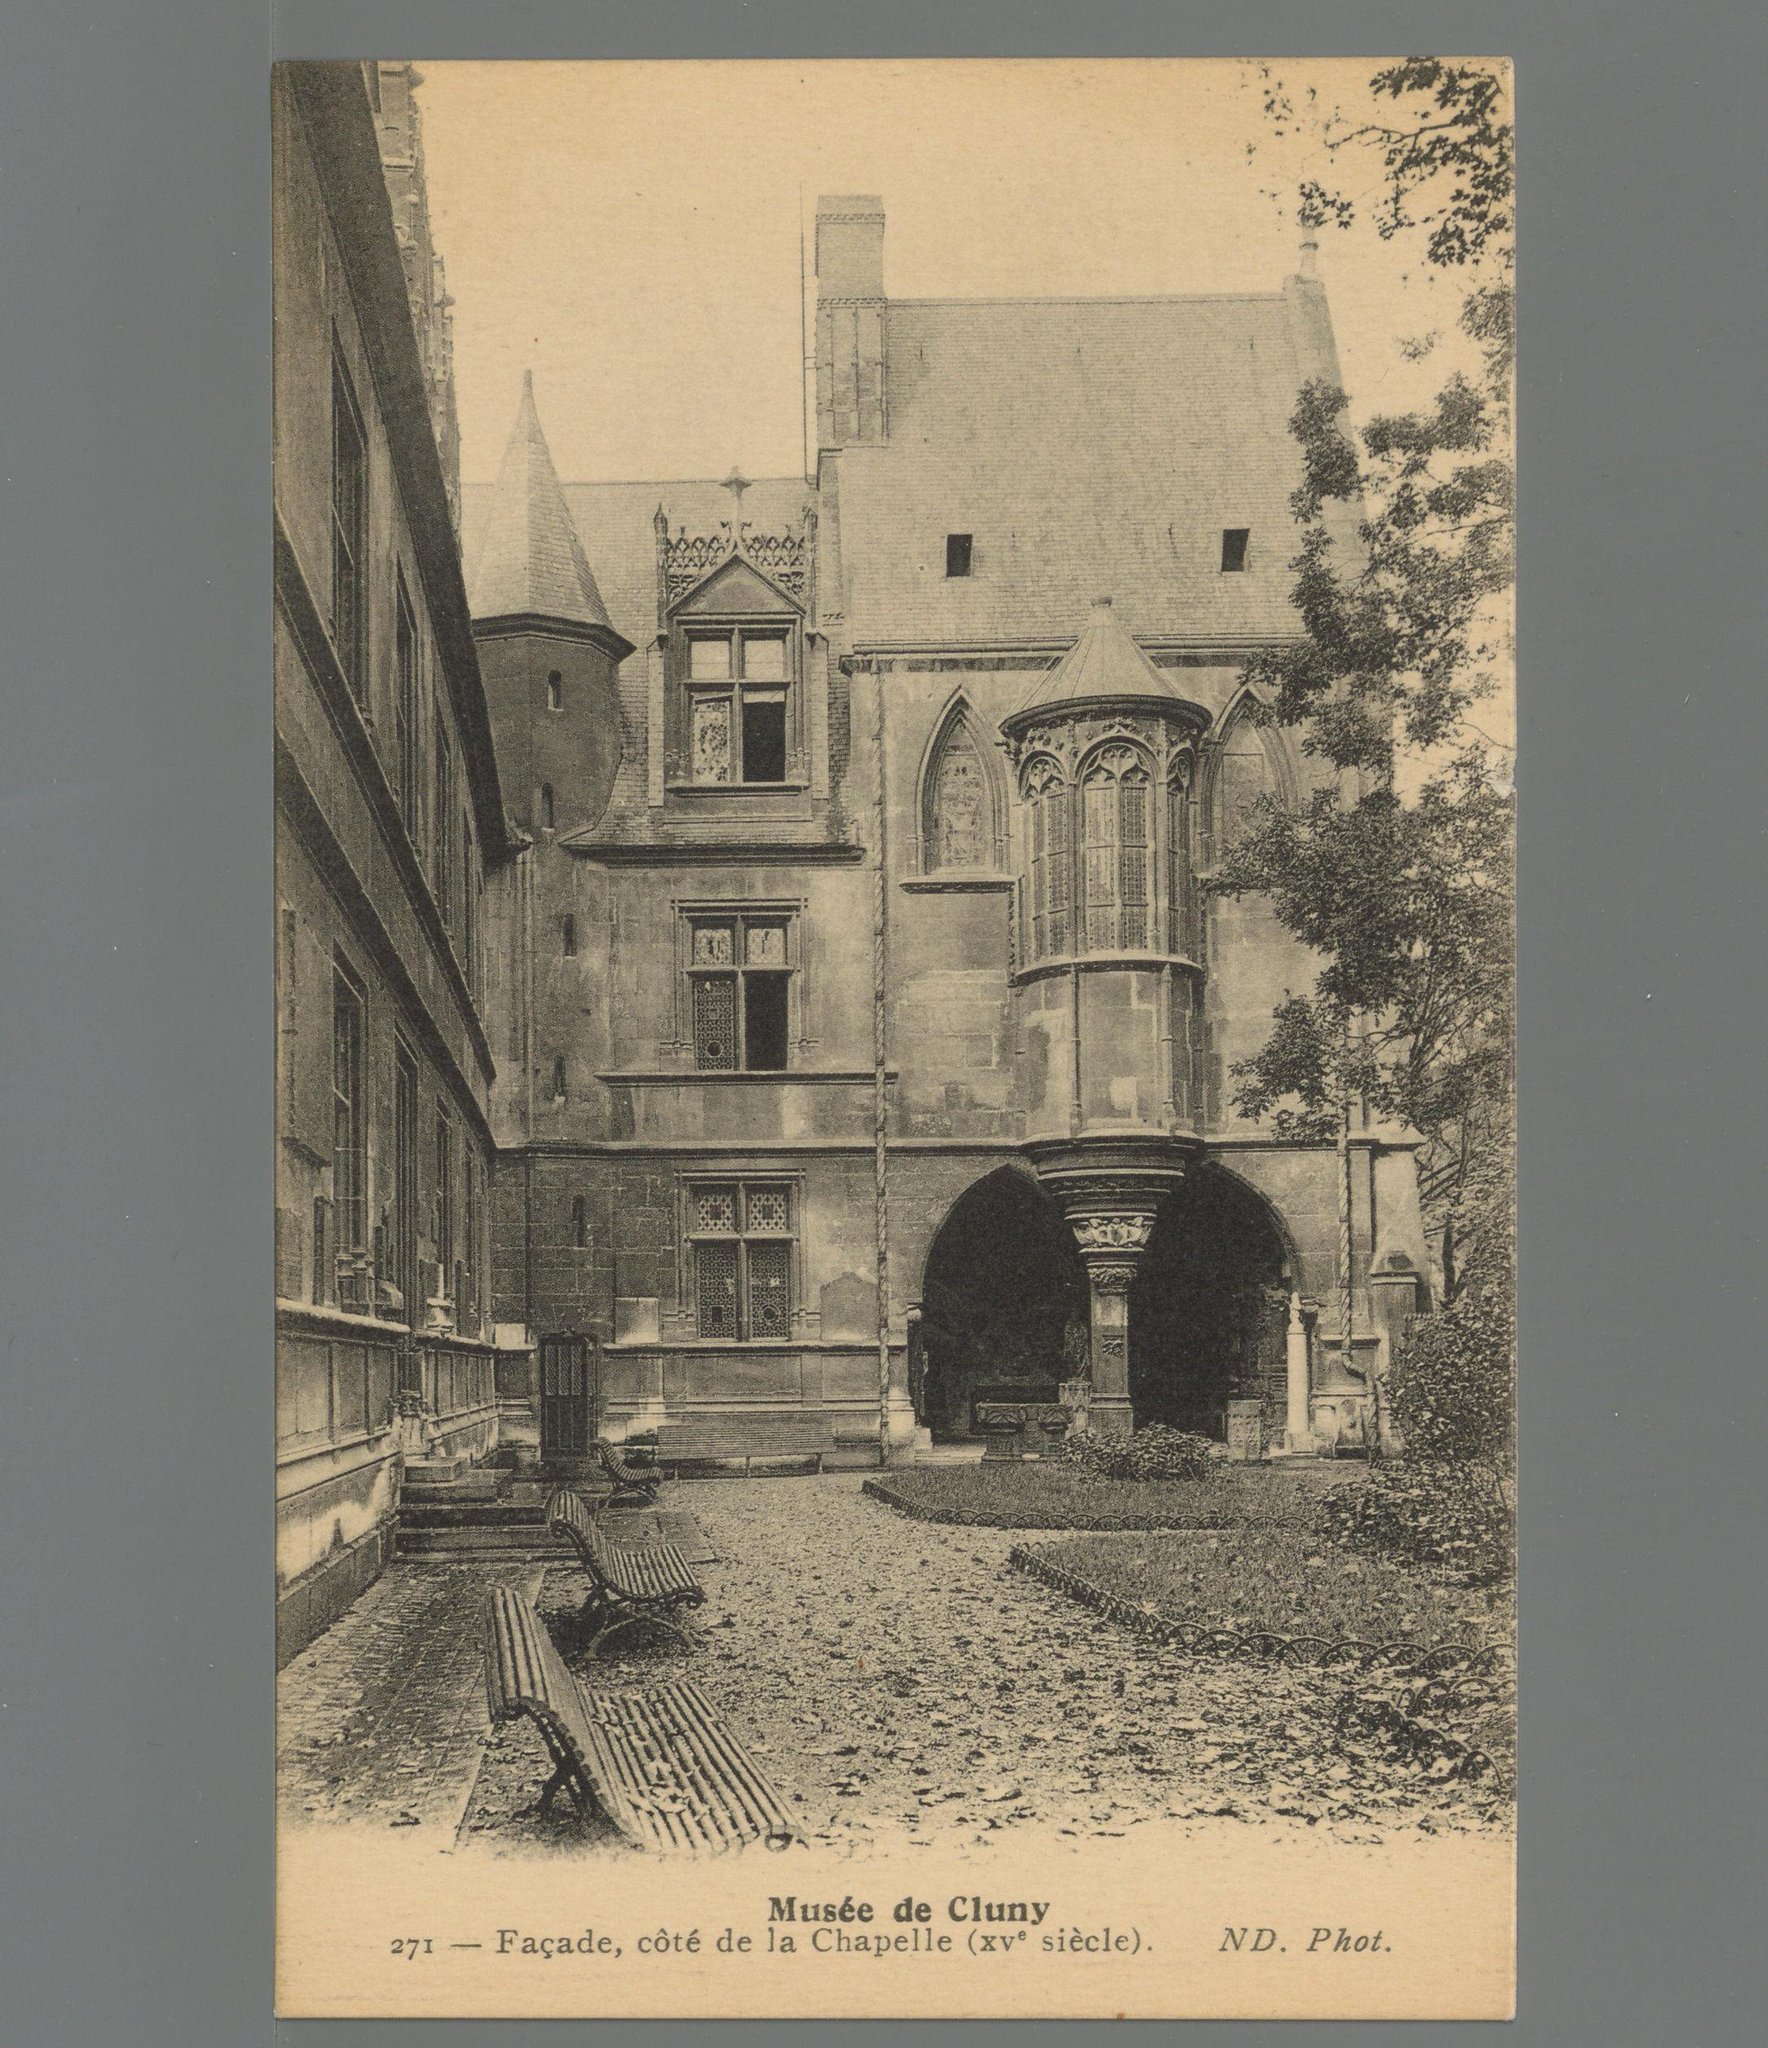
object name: photomechanical print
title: Musée de Cluny. Façade, côté de la Chapelle (XVe siècle)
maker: Anonymous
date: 1920-1932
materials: cardboard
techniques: photograph, writing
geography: paris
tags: permanent exhibition, museum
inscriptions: postage stamp